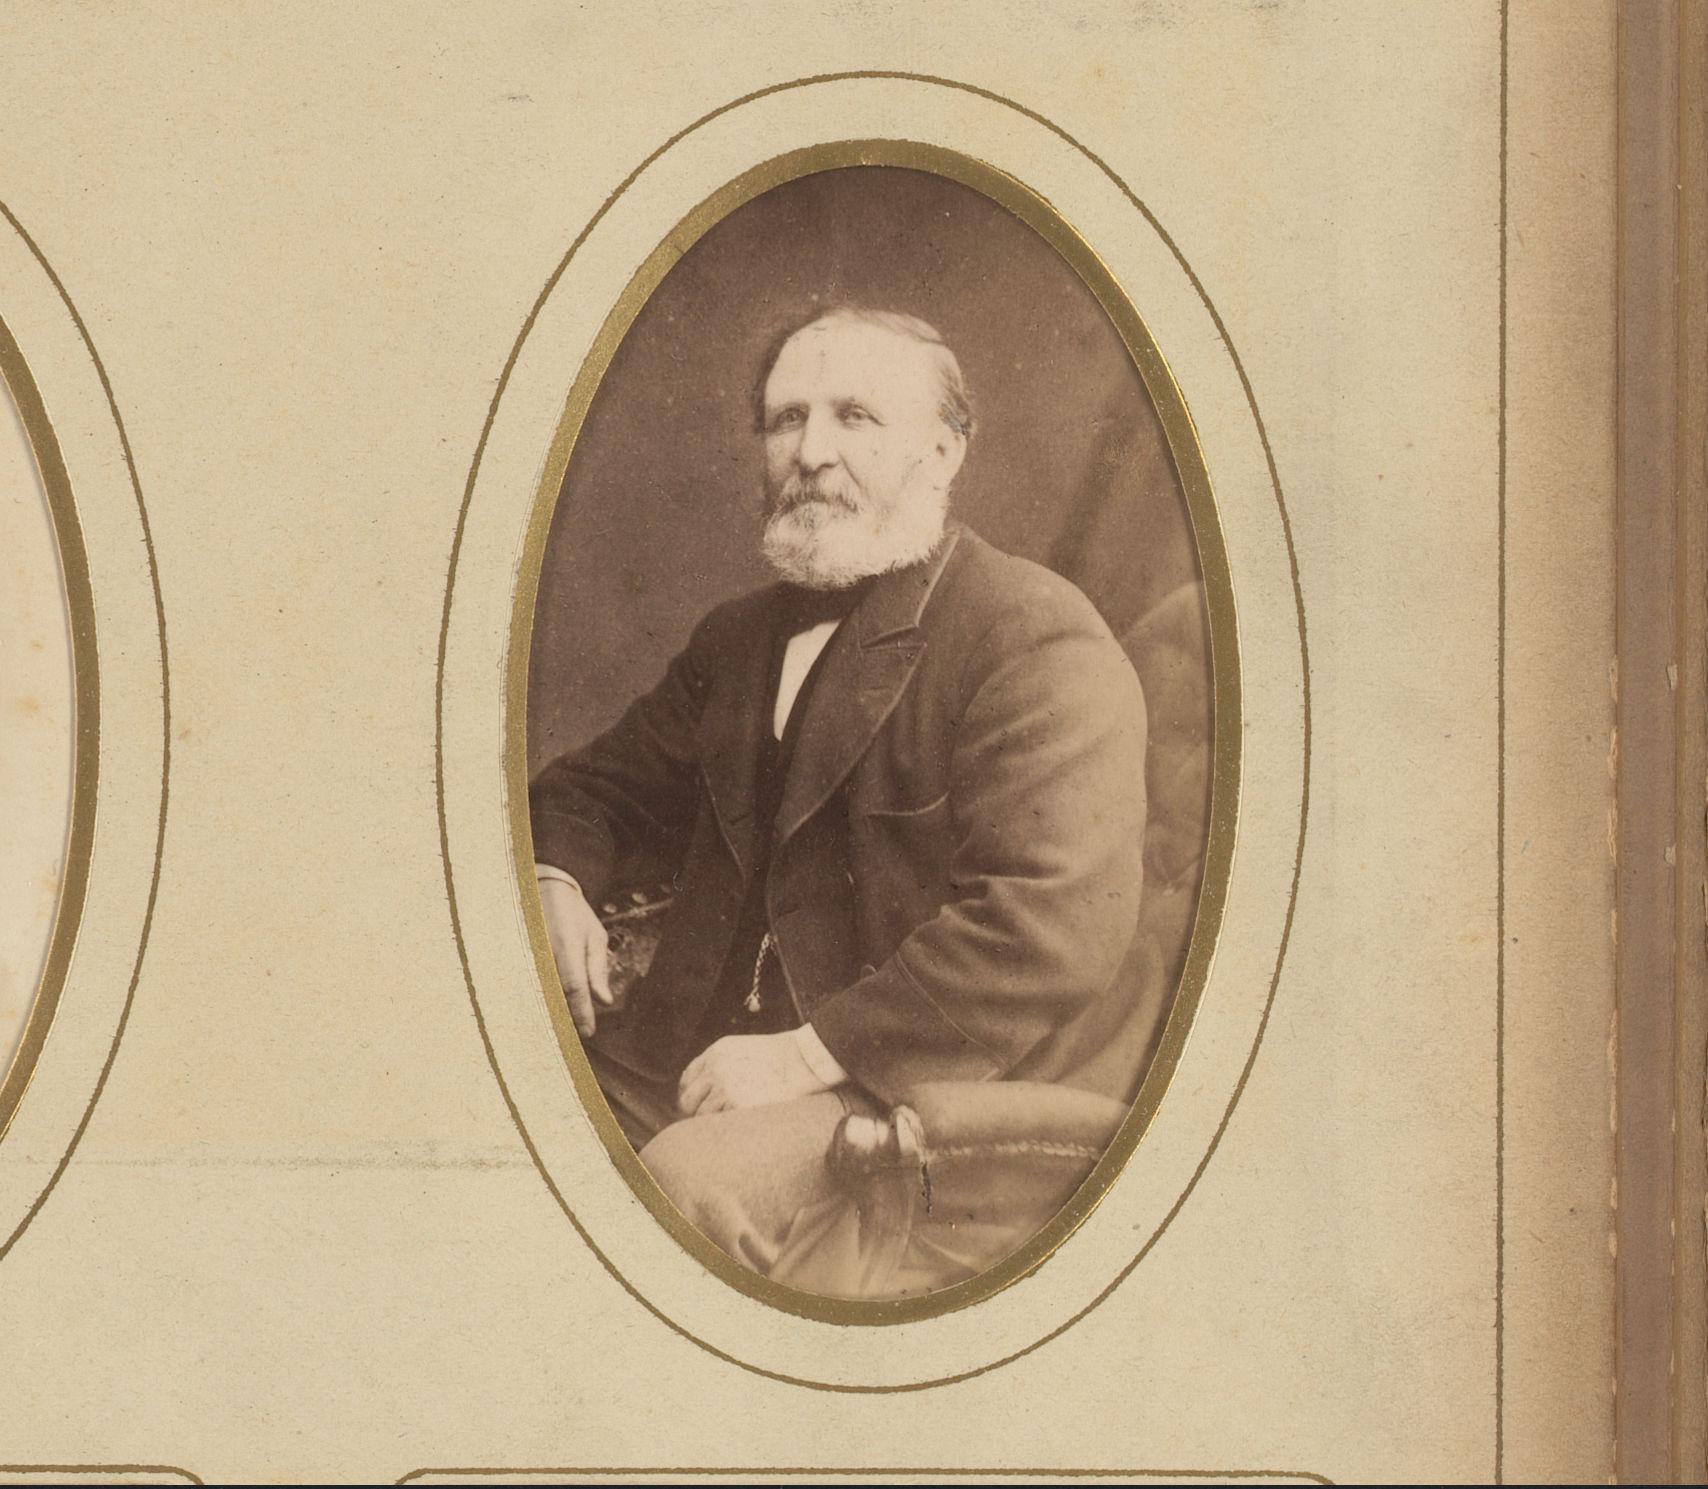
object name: photograph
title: Portret van een man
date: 1863-1887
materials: cardboard, photographic support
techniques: albumen print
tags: sitting figure, moustache, adult man, historical persons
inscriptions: number: ‘69713’, inscription: ‘T.J. Barnes & Son/ 422/ Mile End Road/ London E (...)’